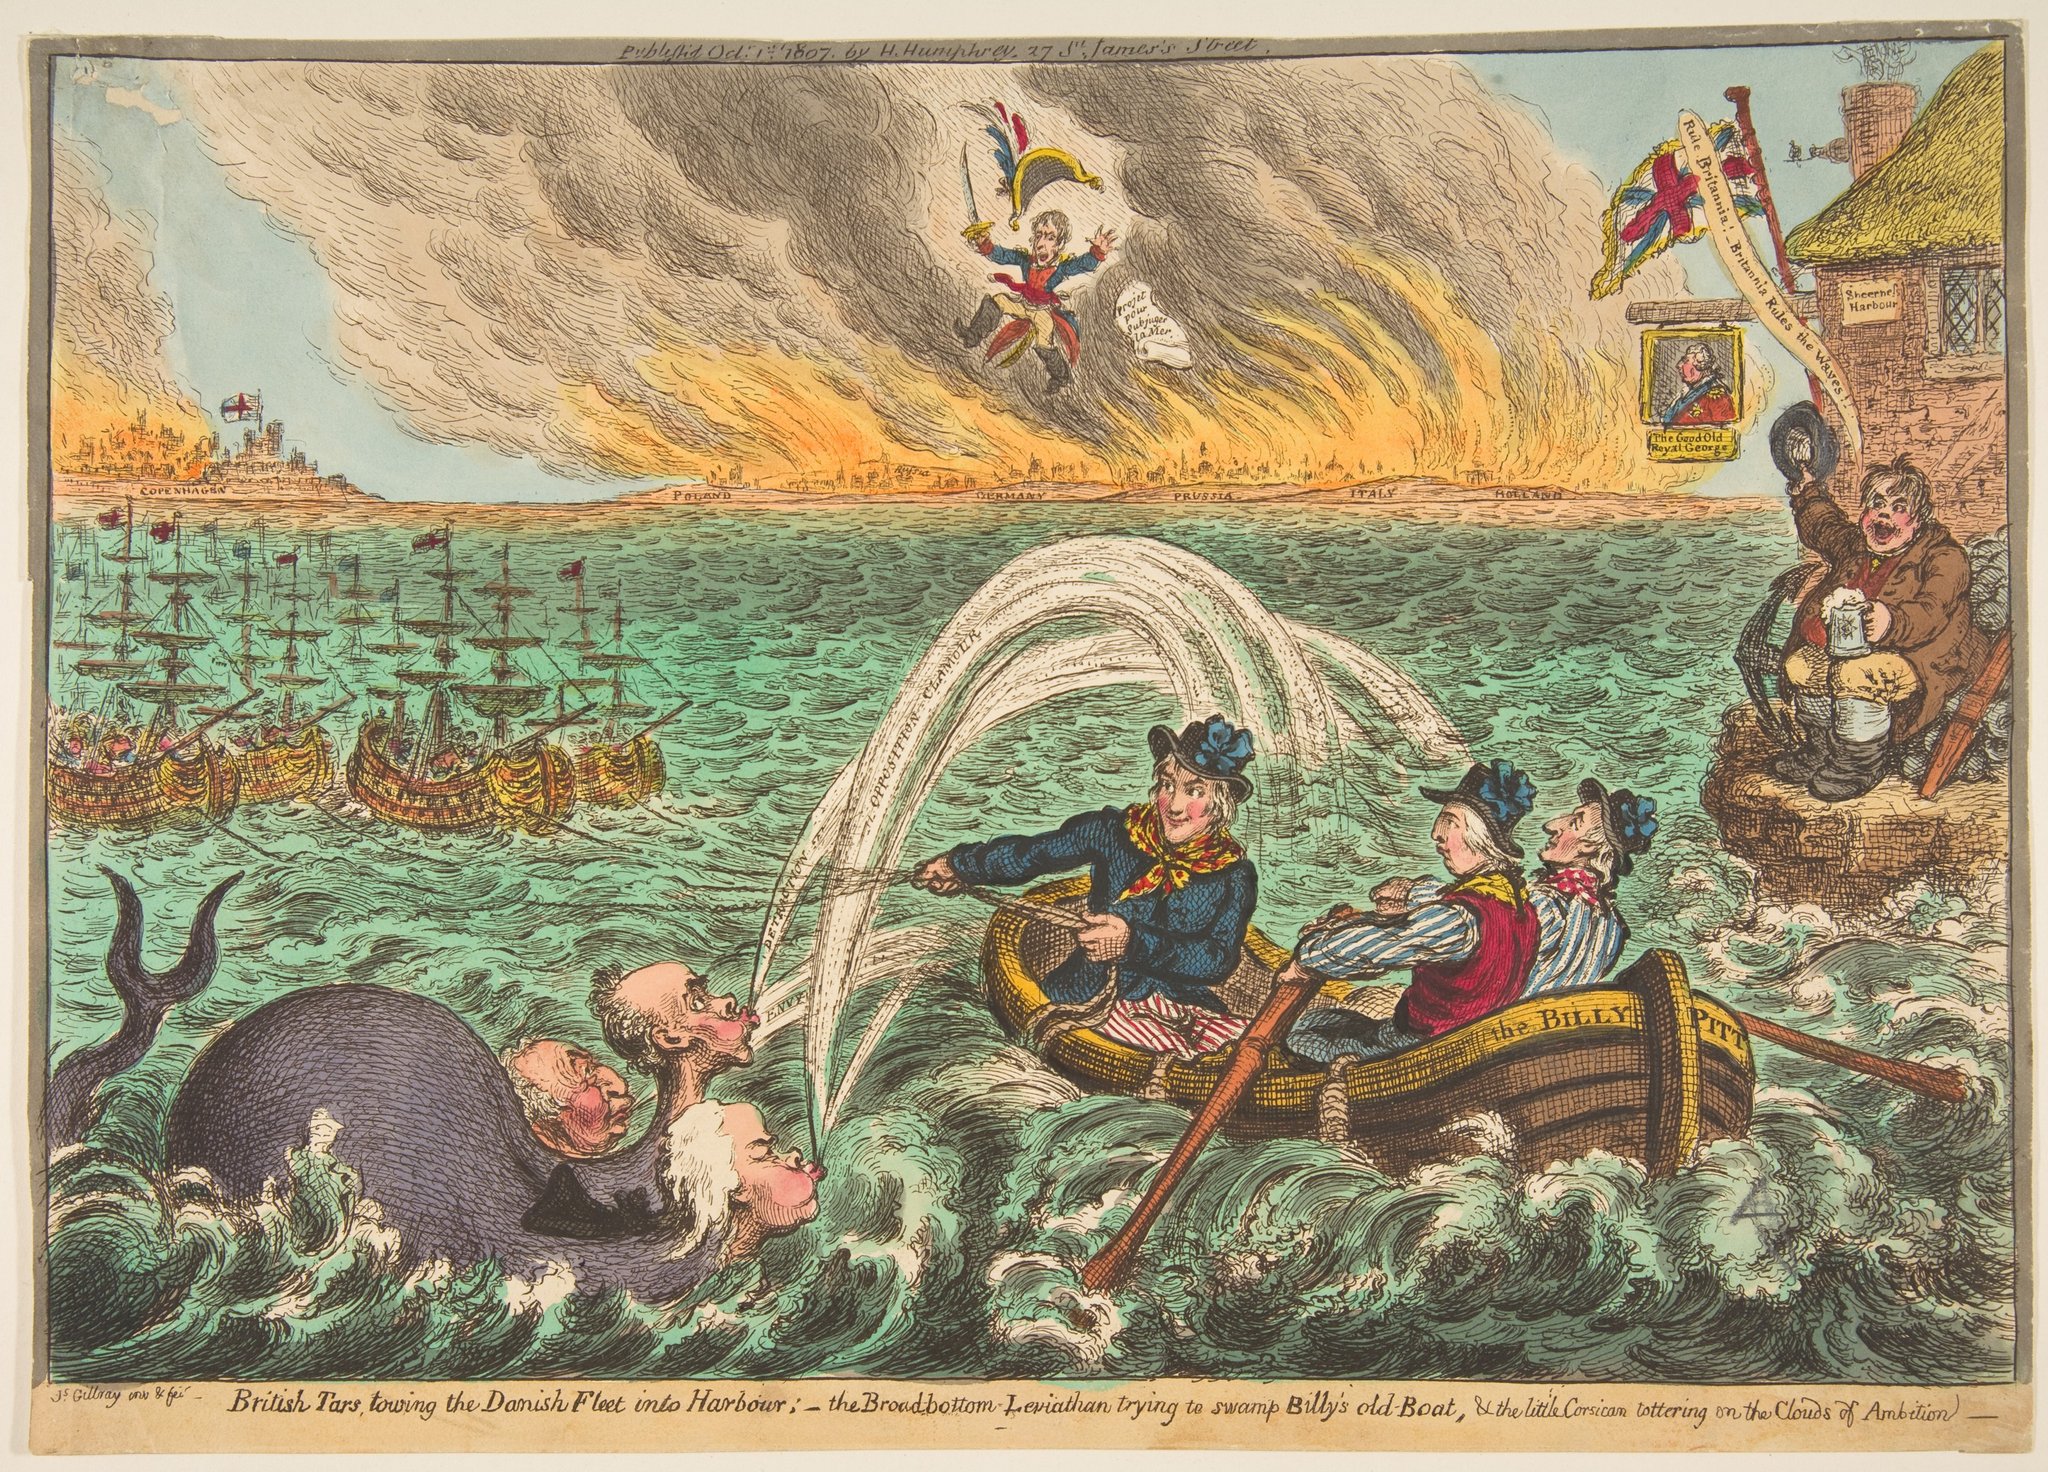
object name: print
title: British Tars Towing the Danish Fleet into Harbour; the Broad-Bottom Leviathan trying Billy's Old Boat, and the Little Corsican tottering on the Clouds of Ambition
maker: james gillray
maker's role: artist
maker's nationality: british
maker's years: 1756-1815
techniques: etching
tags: satire,men,fires,boats,politics